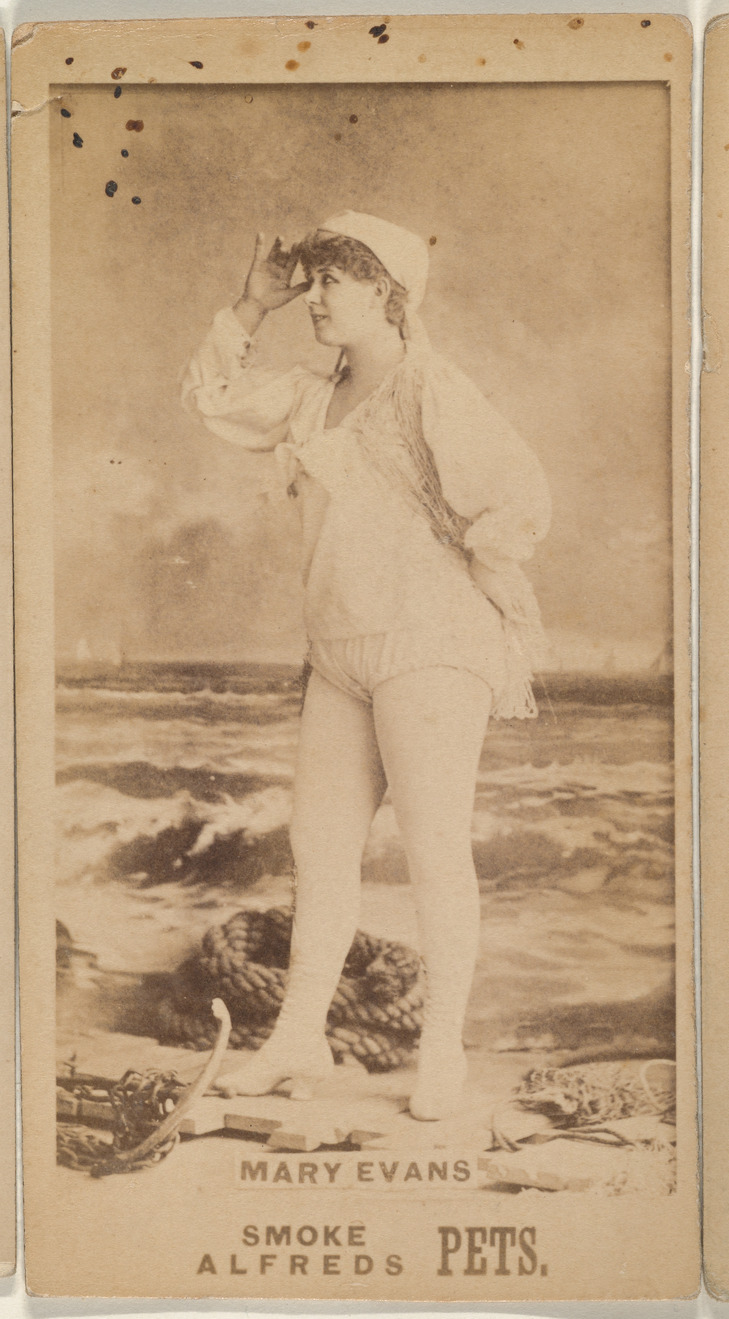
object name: photograph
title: Mary Evans, from the Actresses series (N671), promoting Alfreds Pets Tobacco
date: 1888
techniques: albumen silver print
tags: portraits,women,actresses